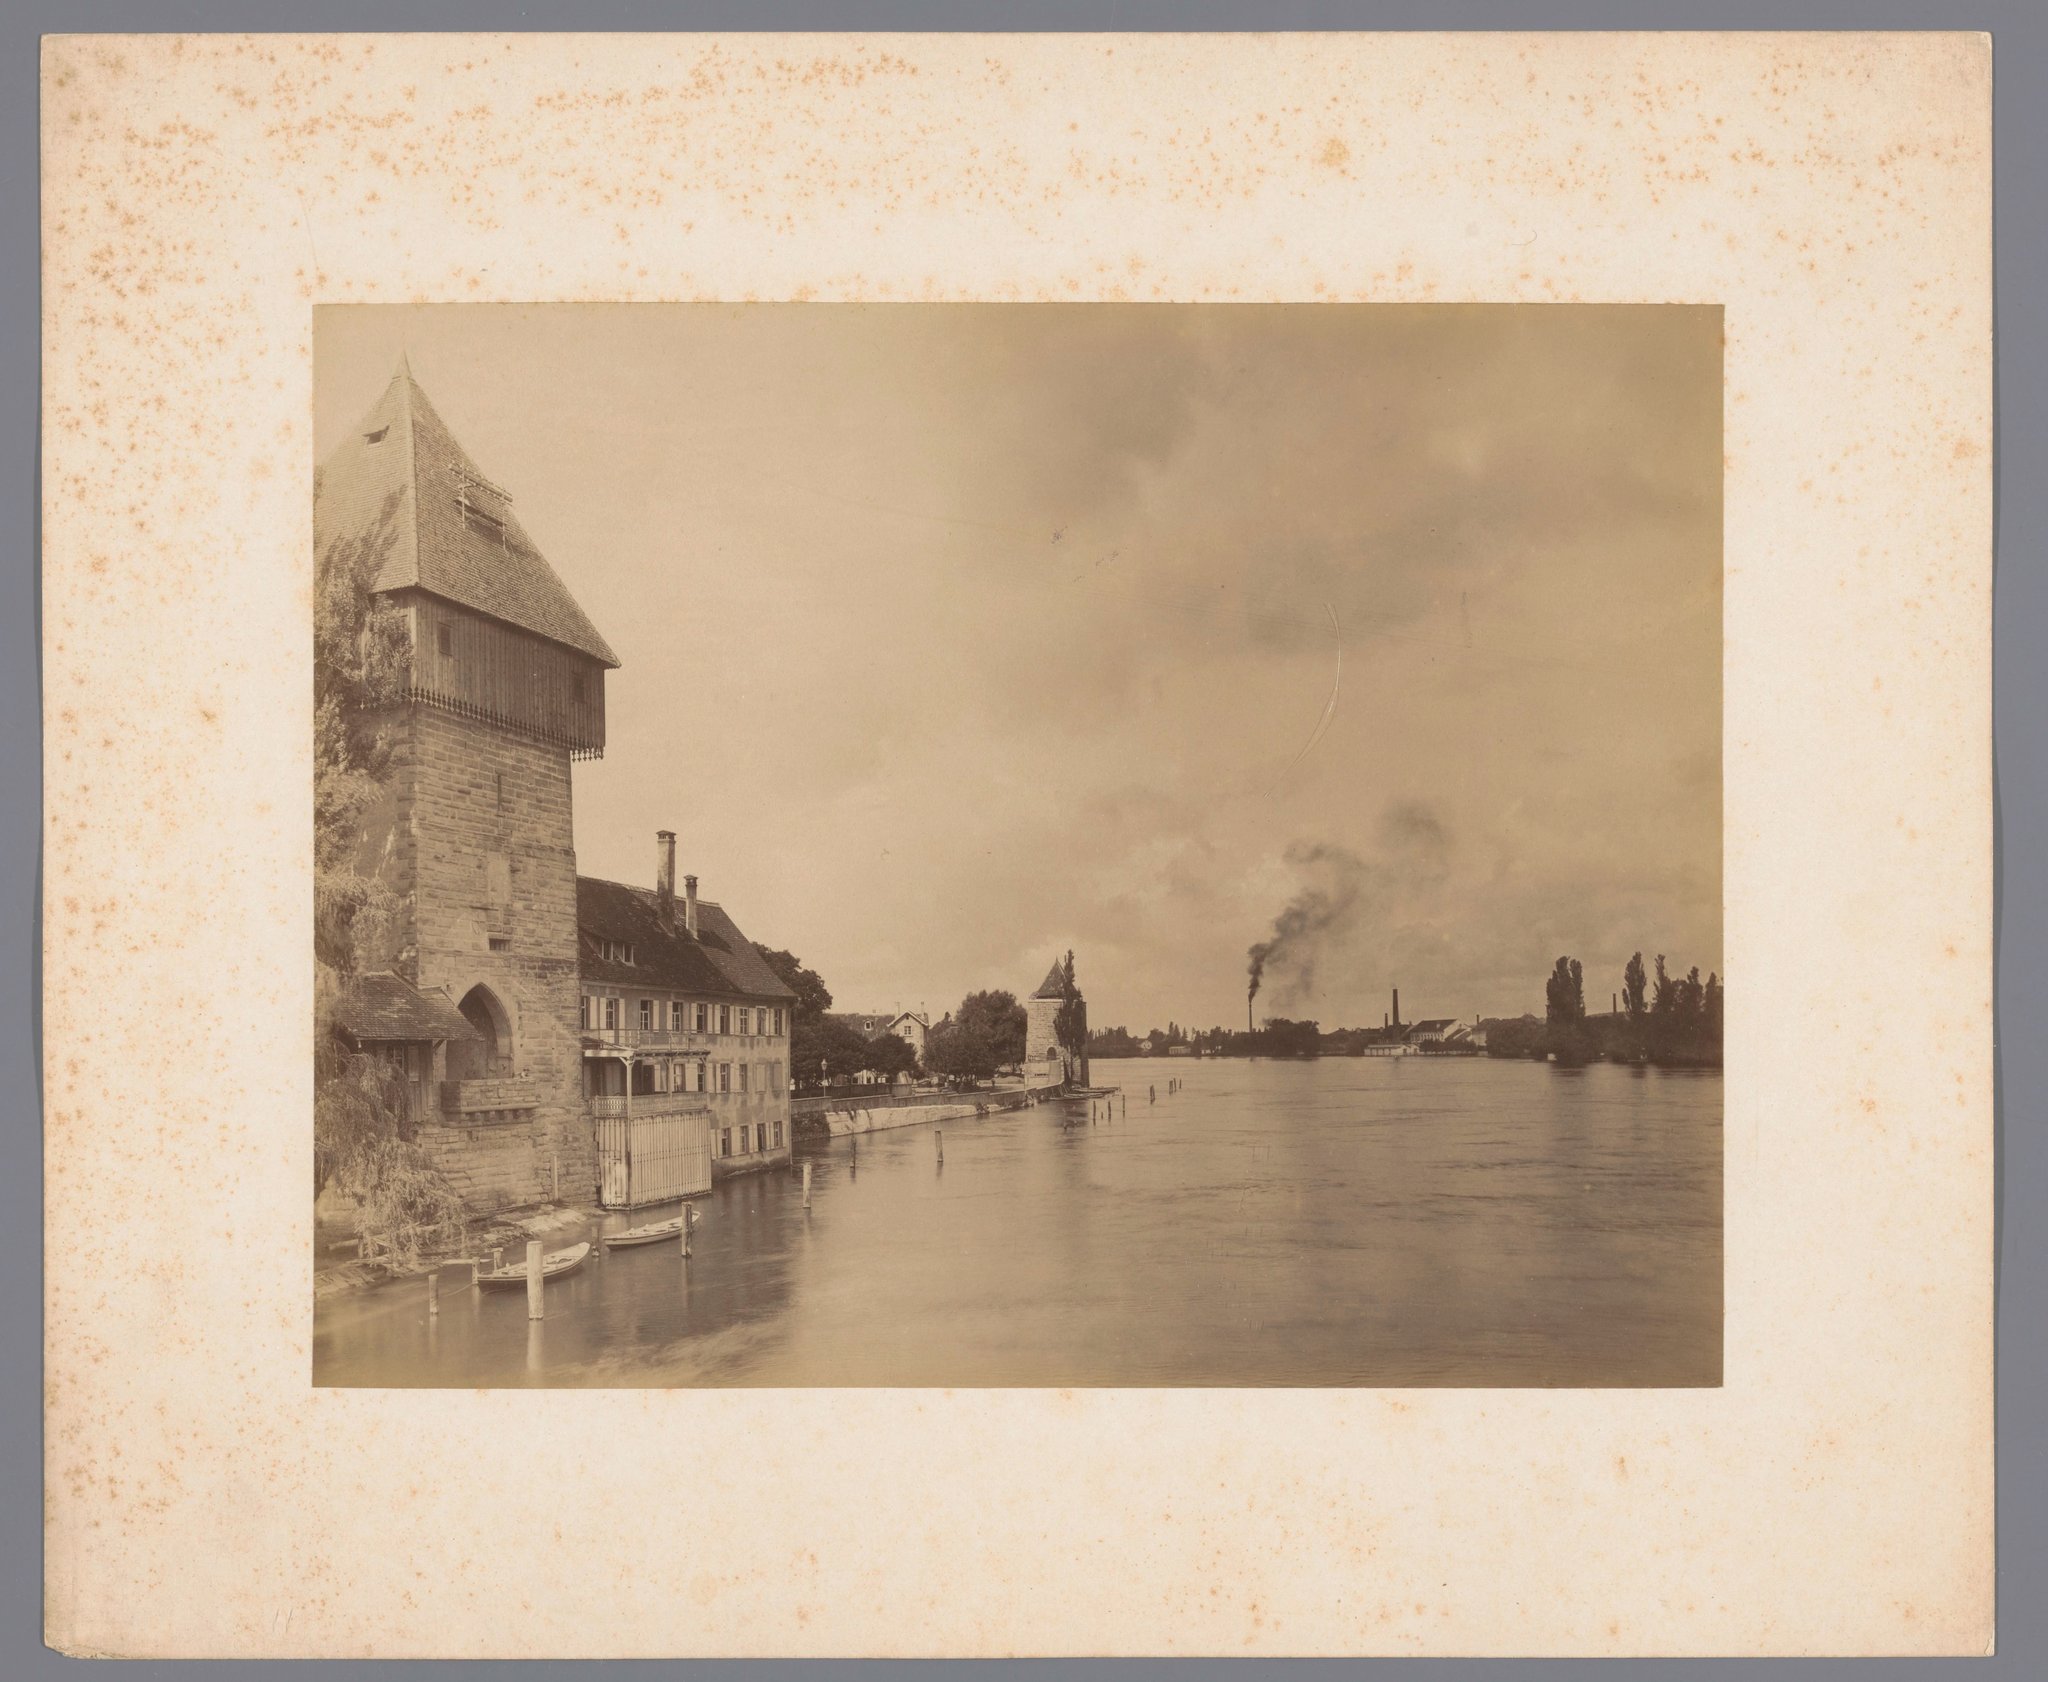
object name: photograph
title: Gezicht op de Rijn bij Konstanz, met links de Rheintorturm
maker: Anonymous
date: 1883-1900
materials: cardboard, paper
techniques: albumen print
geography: konstanz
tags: smoke-stack, tower, clock tower ~ monumental adornment, river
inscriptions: inscription: ‘27 Constanz Bodensee/ Zondag 5 juli/ 27’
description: Deze foto maakt deel uit van een fotoserie, gemaakt of gekocht door een Nederlandse reiziger die onderweg was in Duitsland, Oostenrijk en Italië tussen 27 juni en 29 juli. Het jaartal van de reis is onbekend, maar de foto's zijn waarschijnlijk gemaakt tussen 1883 en 1900.